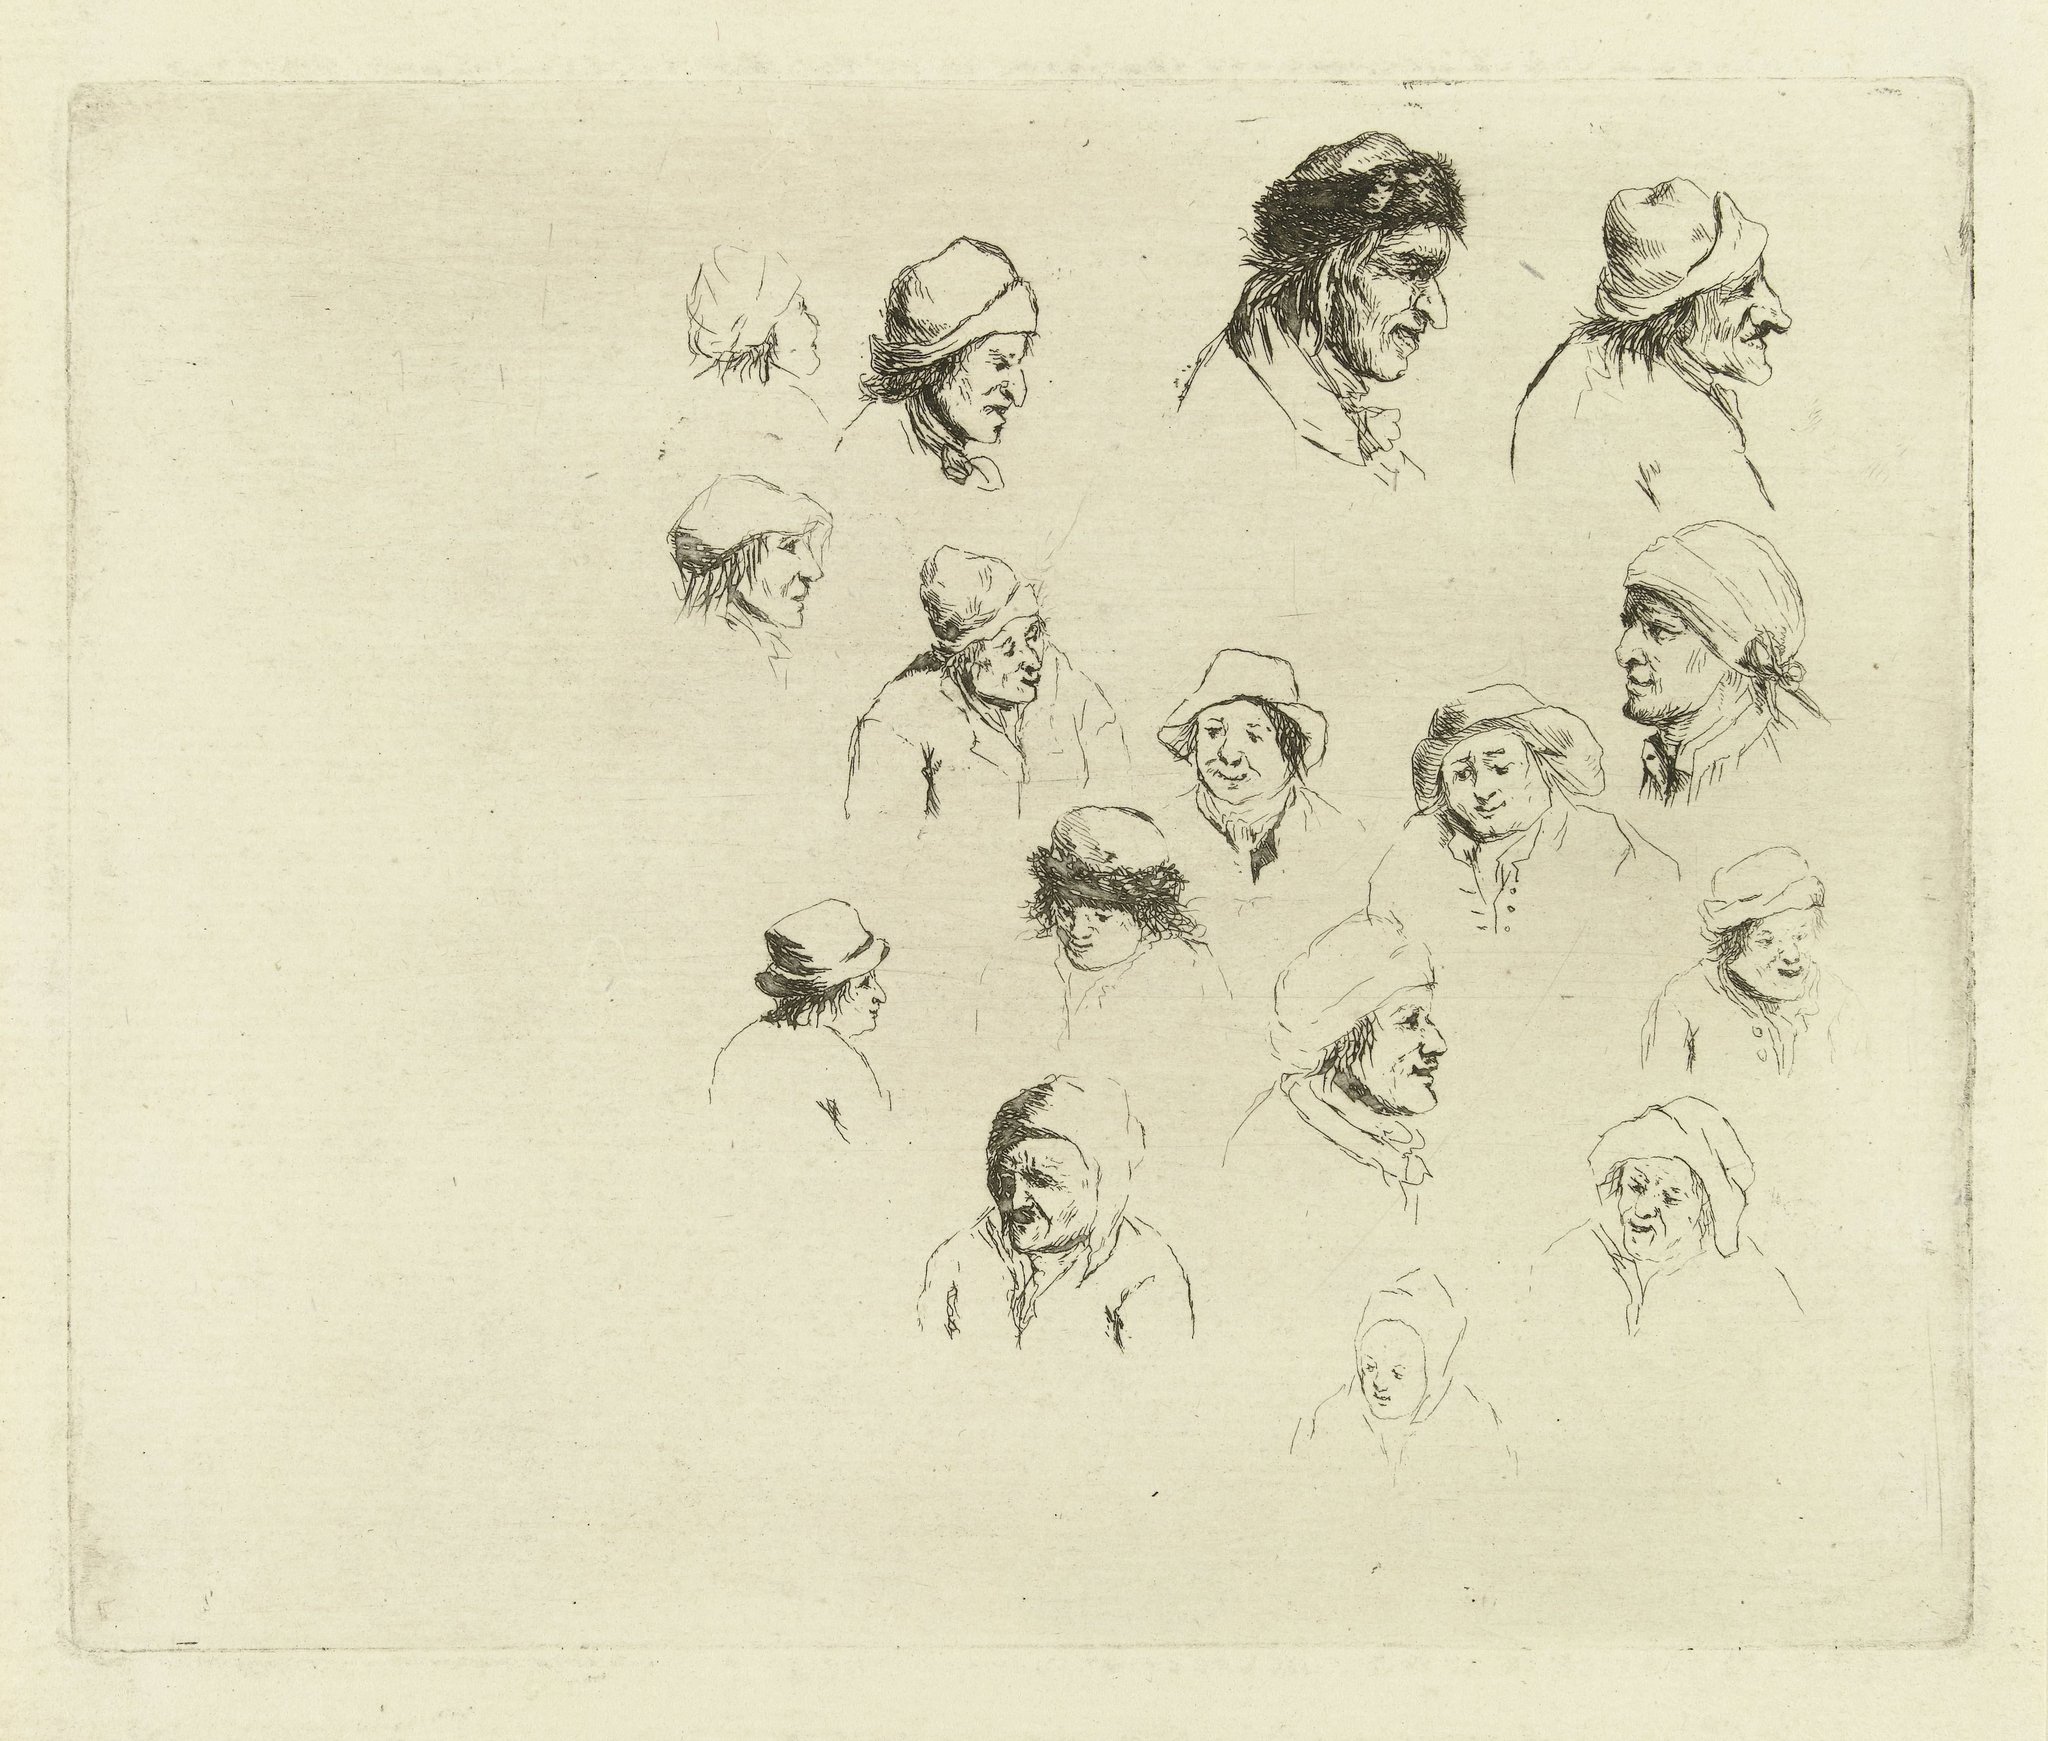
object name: print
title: Studieblad met zestien hoofden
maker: marie lambertine coclers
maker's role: conservator, draughtsman, print maker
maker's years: 1761-1815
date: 1776-1815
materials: paper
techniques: etching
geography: amsterdam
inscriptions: collector's mark: Lugt 2228